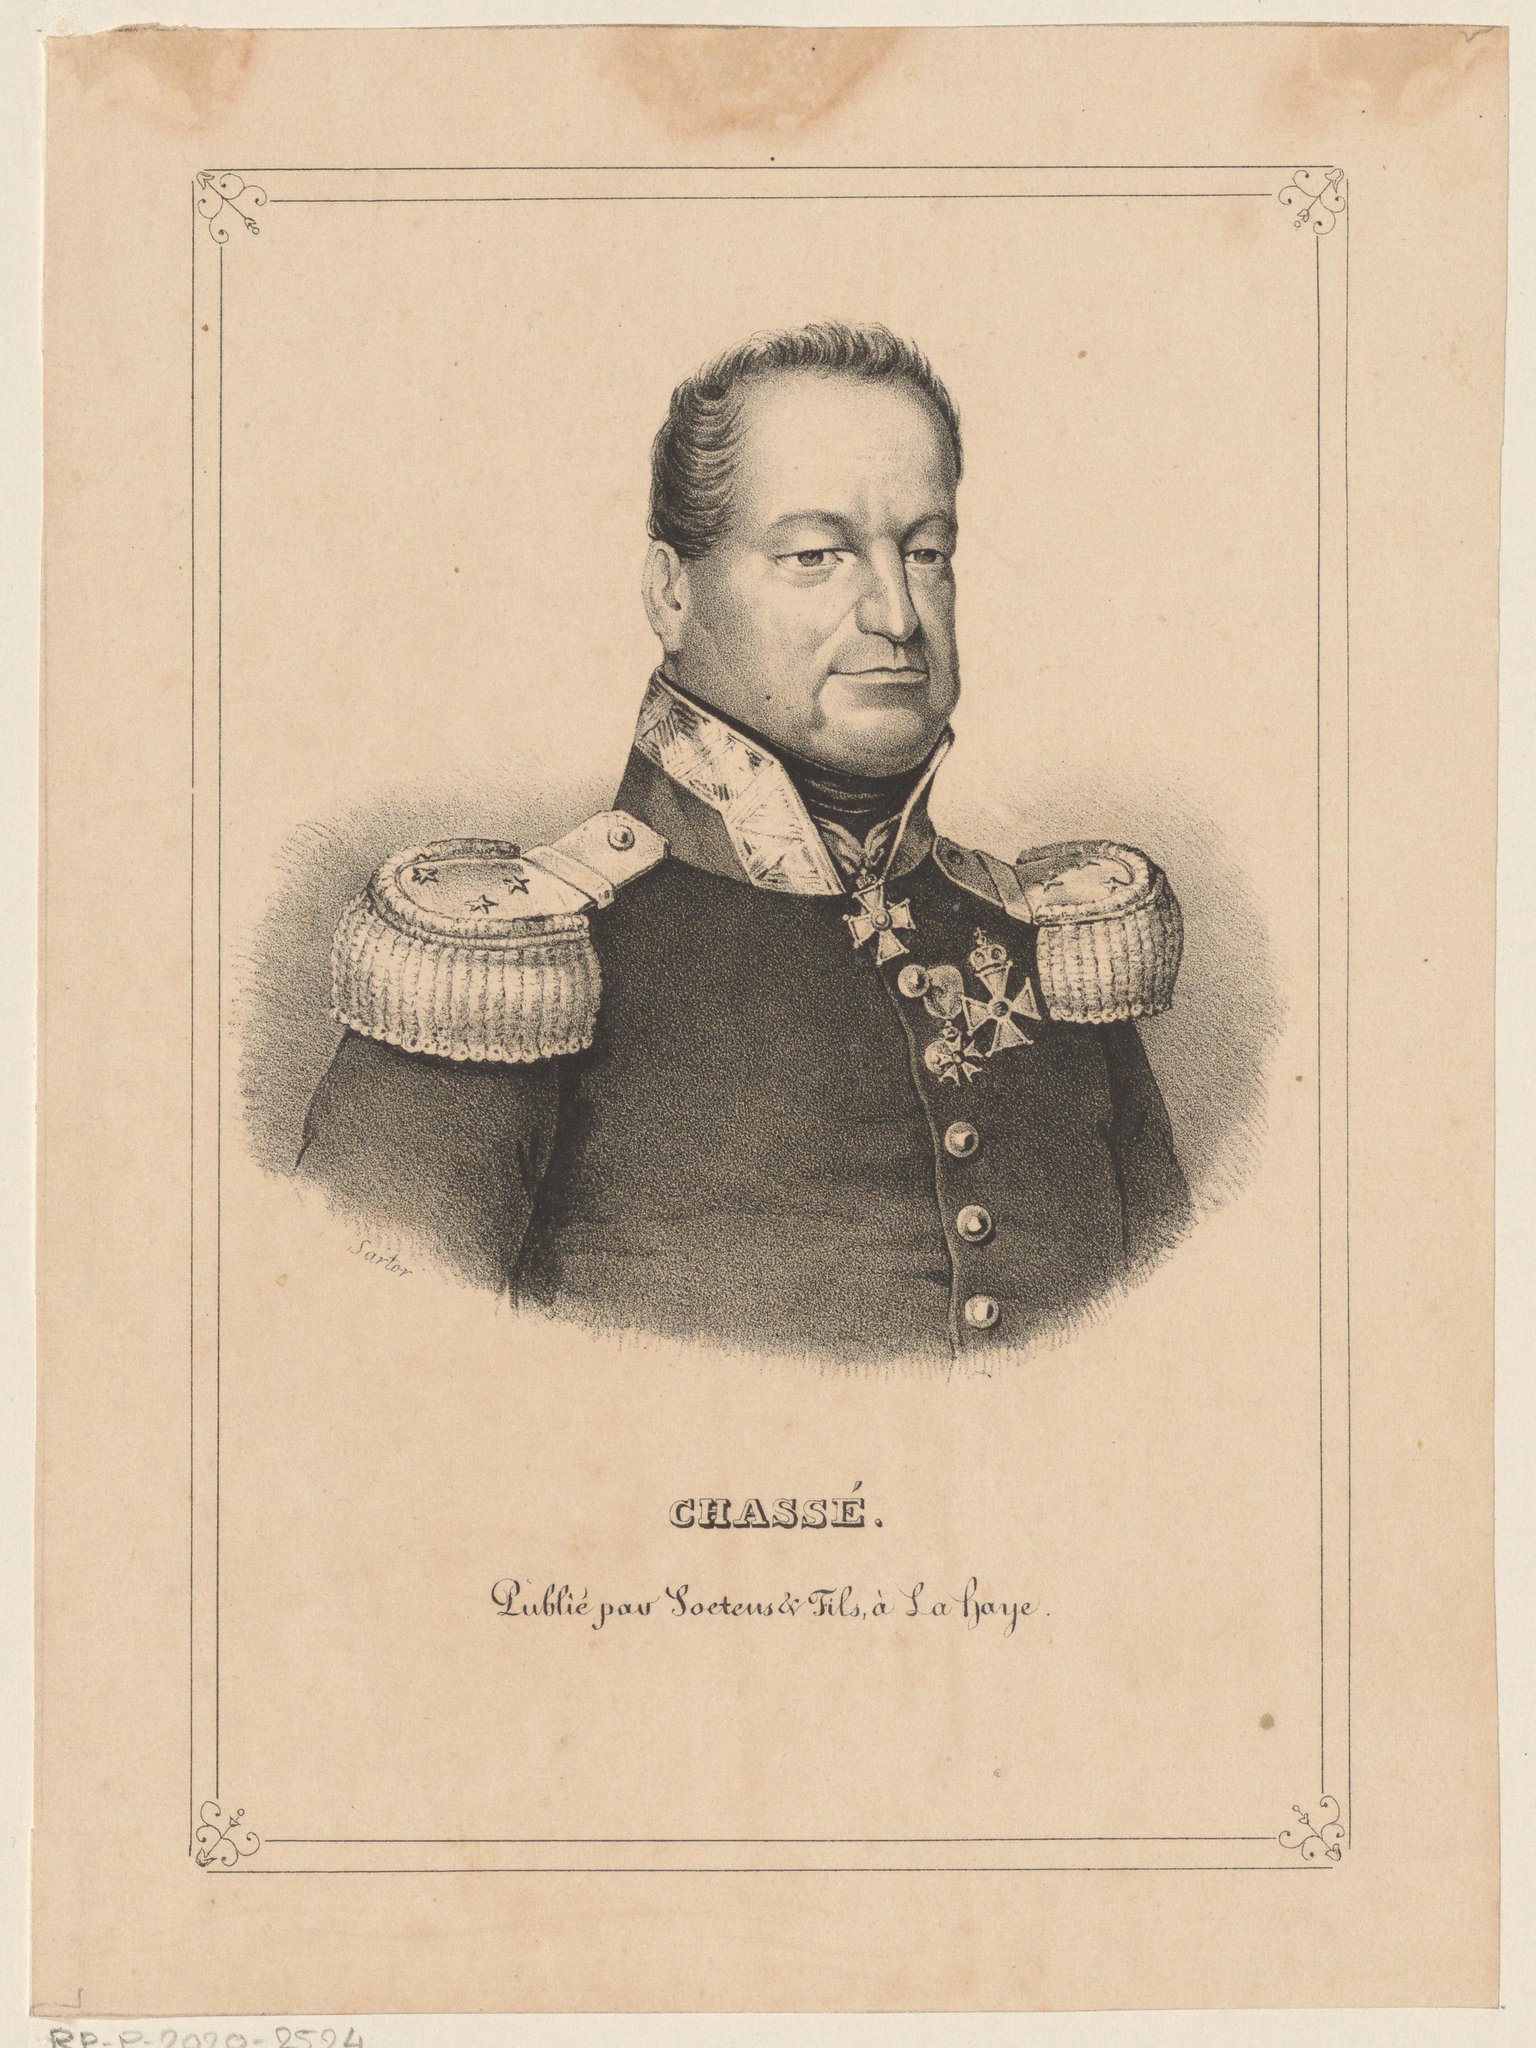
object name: print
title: Portret van David Hendrik baron Chassé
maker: hendrik frederik sartor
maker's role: draughtsman, print maker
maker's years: 1818-1881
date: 1837-1840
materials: paper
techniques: lithograph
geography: the hague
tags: david hendrik baron chassé, commander-in-chief, general, marshal, historical persons